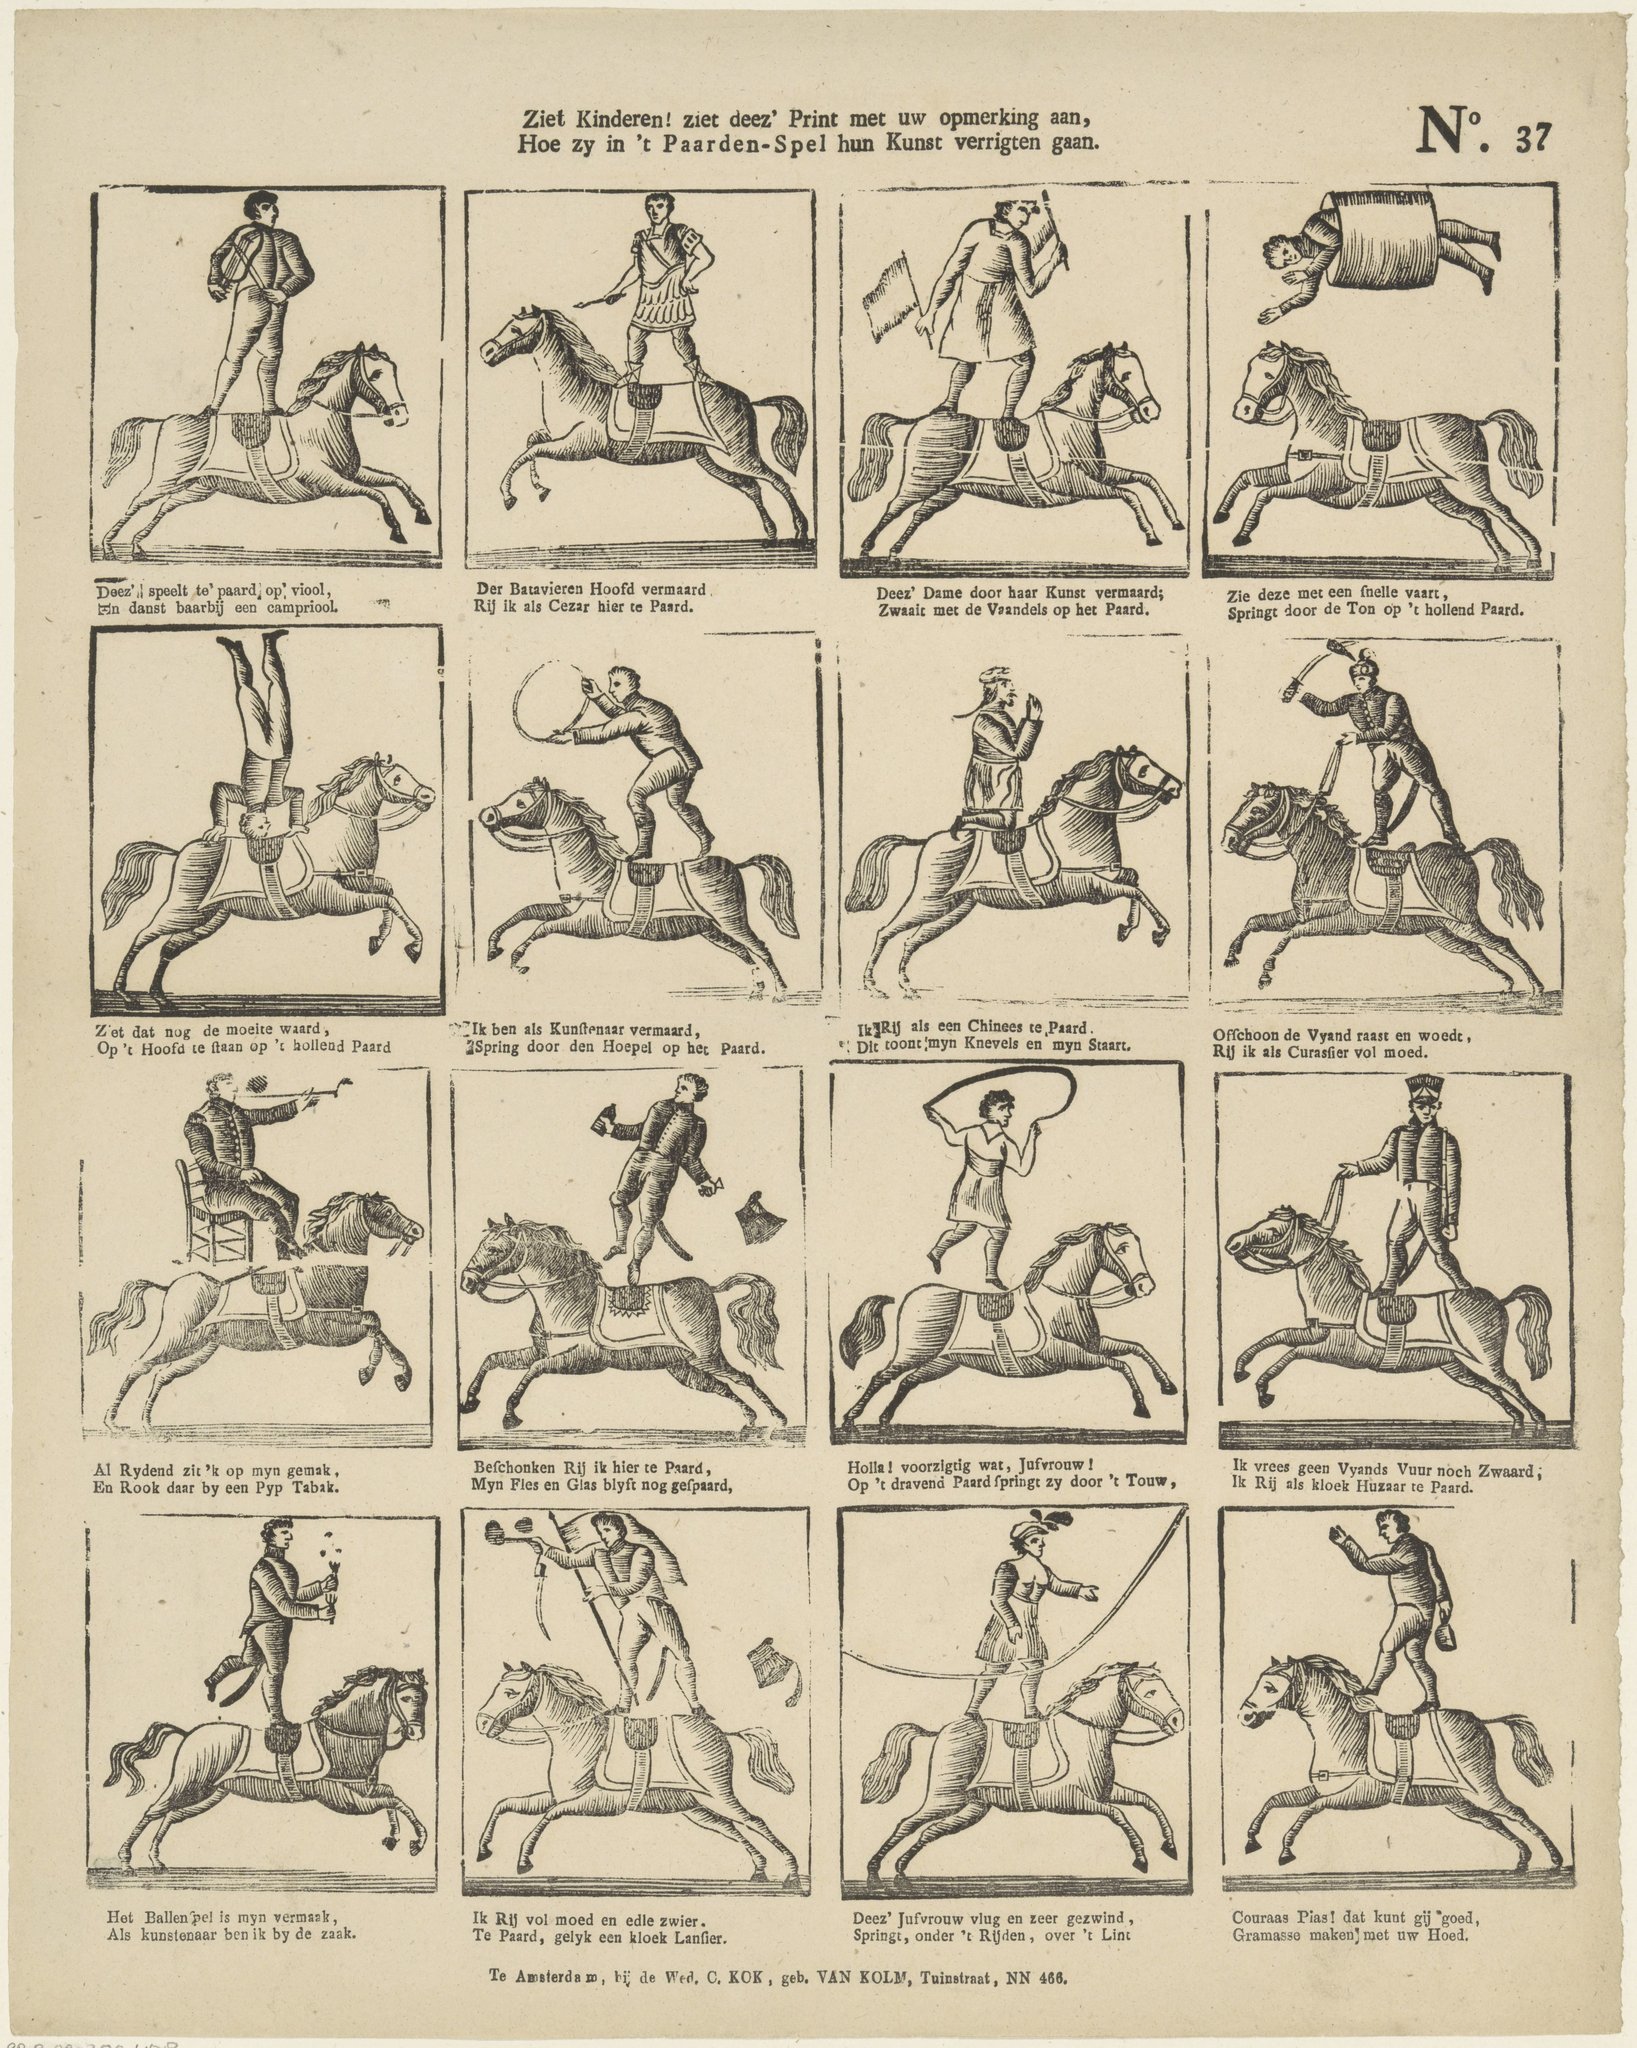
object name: popular print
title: Ziet kinderen! ziet deez' print met uw opmerkingen aan, / Hoe zy in 't paarden-spel hun kunst verrigten gaan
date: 1842-1866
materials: paper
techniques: letterpress printing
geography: amsterdam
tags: riding a horse, ass, or mule; rider, horseman, acrobat ~ circus, horse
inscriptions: collector's mark: Lugt 2760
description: Blad met 16 voorstellingen van mannen die op gekke manieren op een paard rijden, waaronder staand op het paard, springend door een ton en touwtjespringend. Onder elke afbeelding een tweeregelig vers. Genummerd rechtsboven: No. 37.